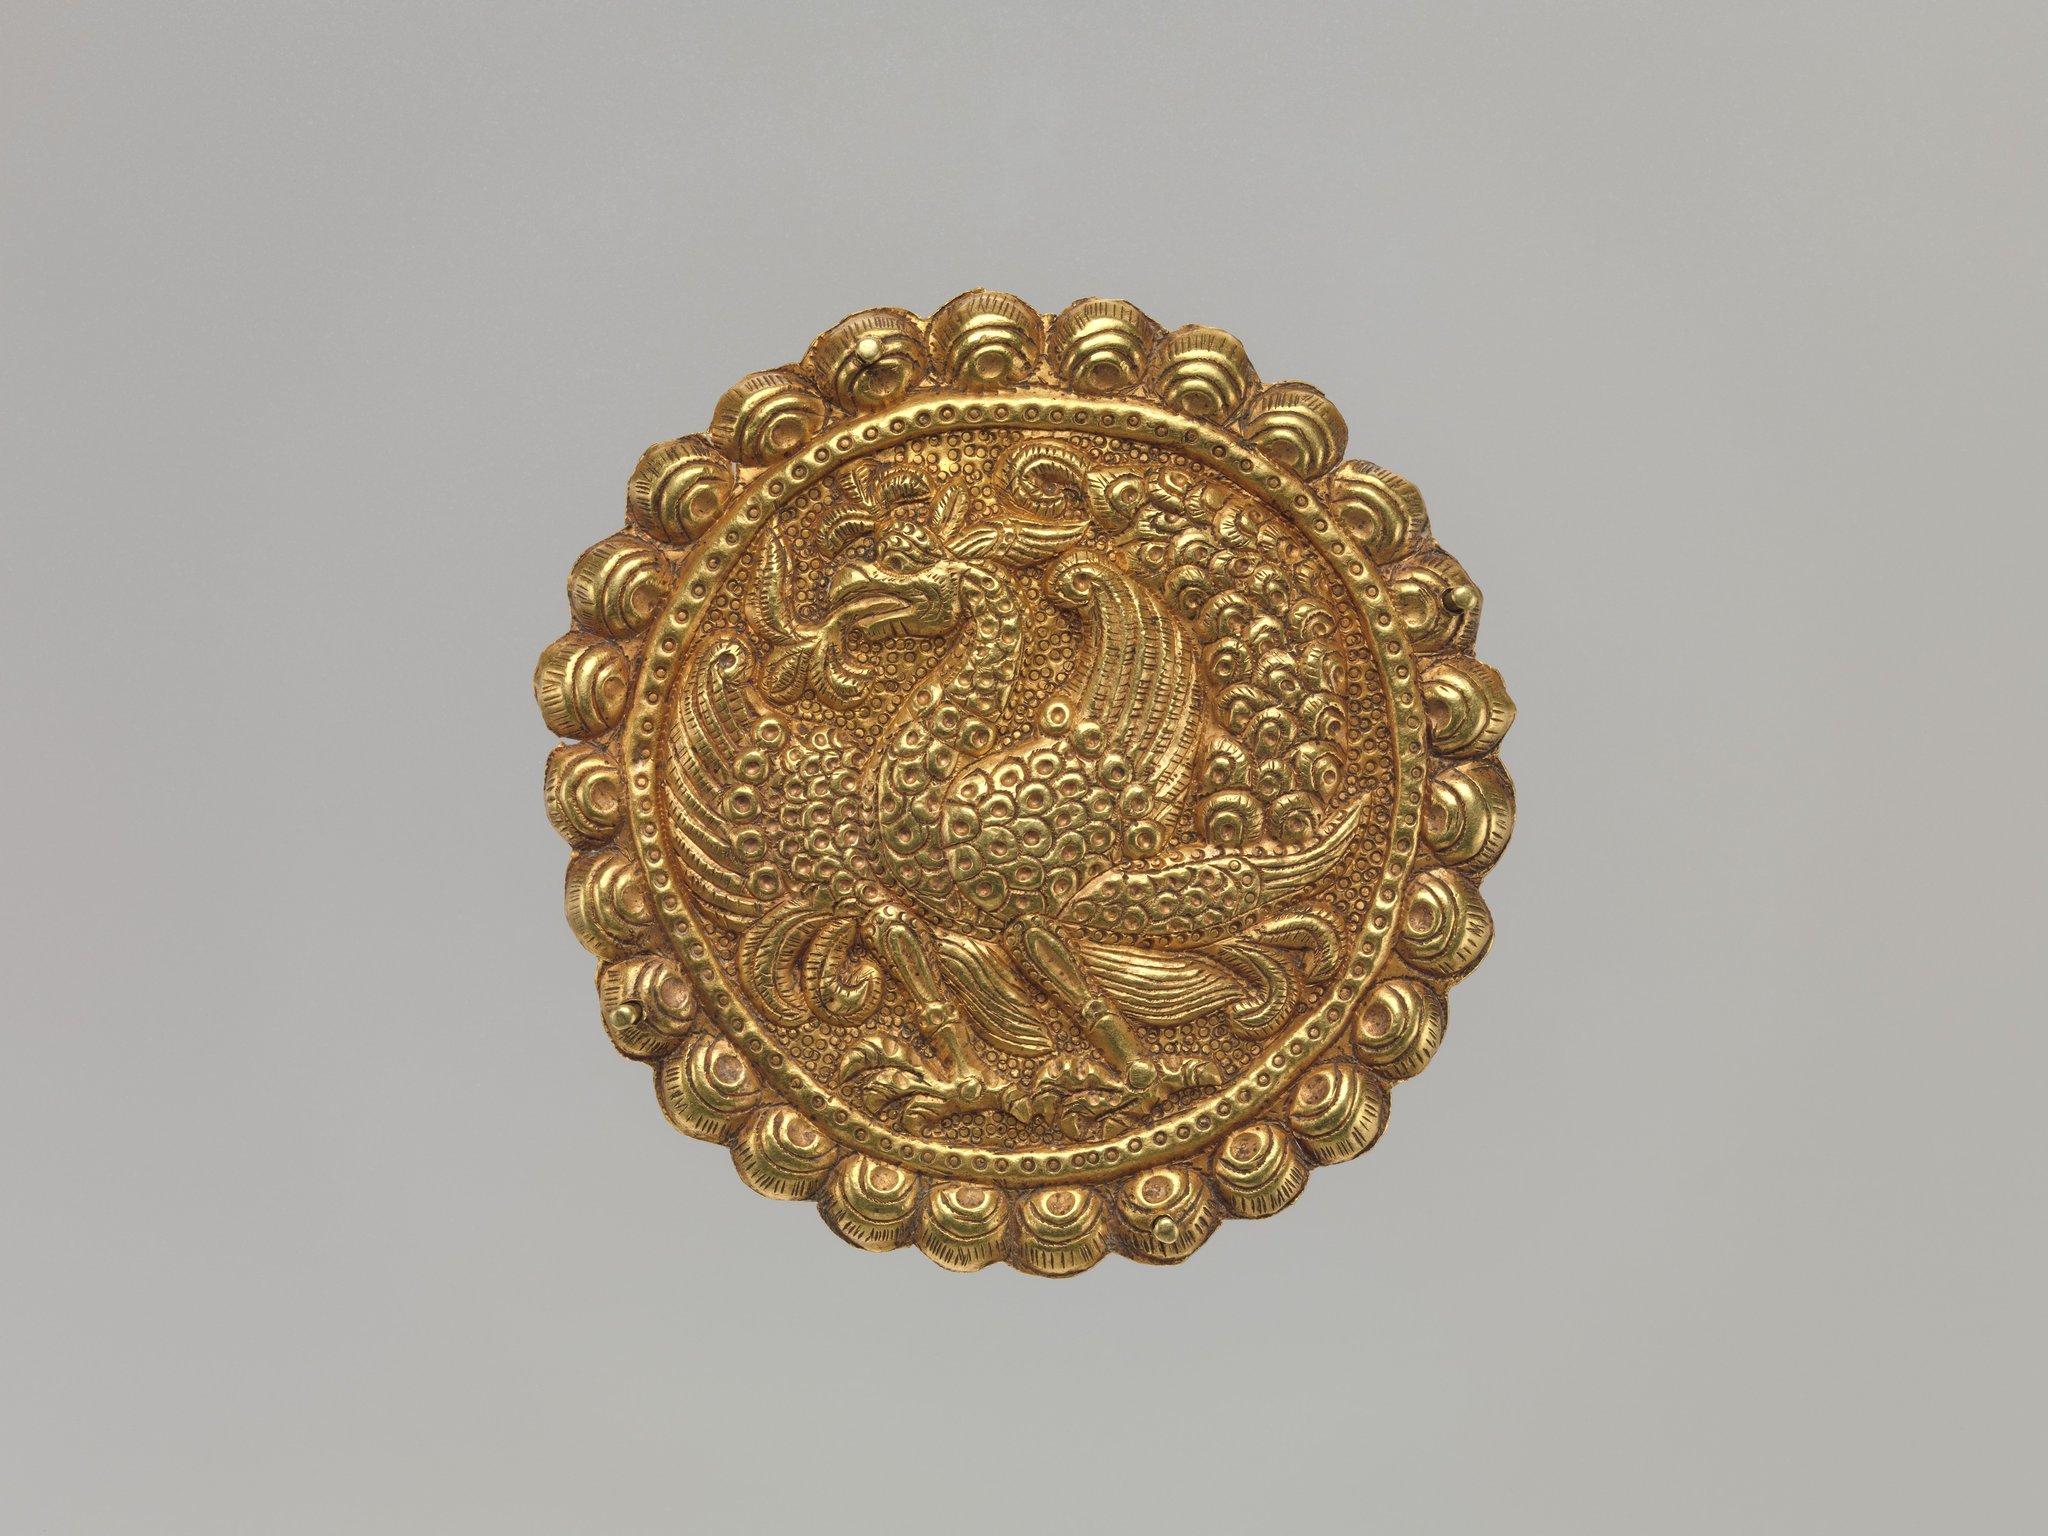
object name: plaque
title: Plaque with Phoenix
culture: chinese or central asian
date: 601-900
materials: gold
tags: mythical creatures